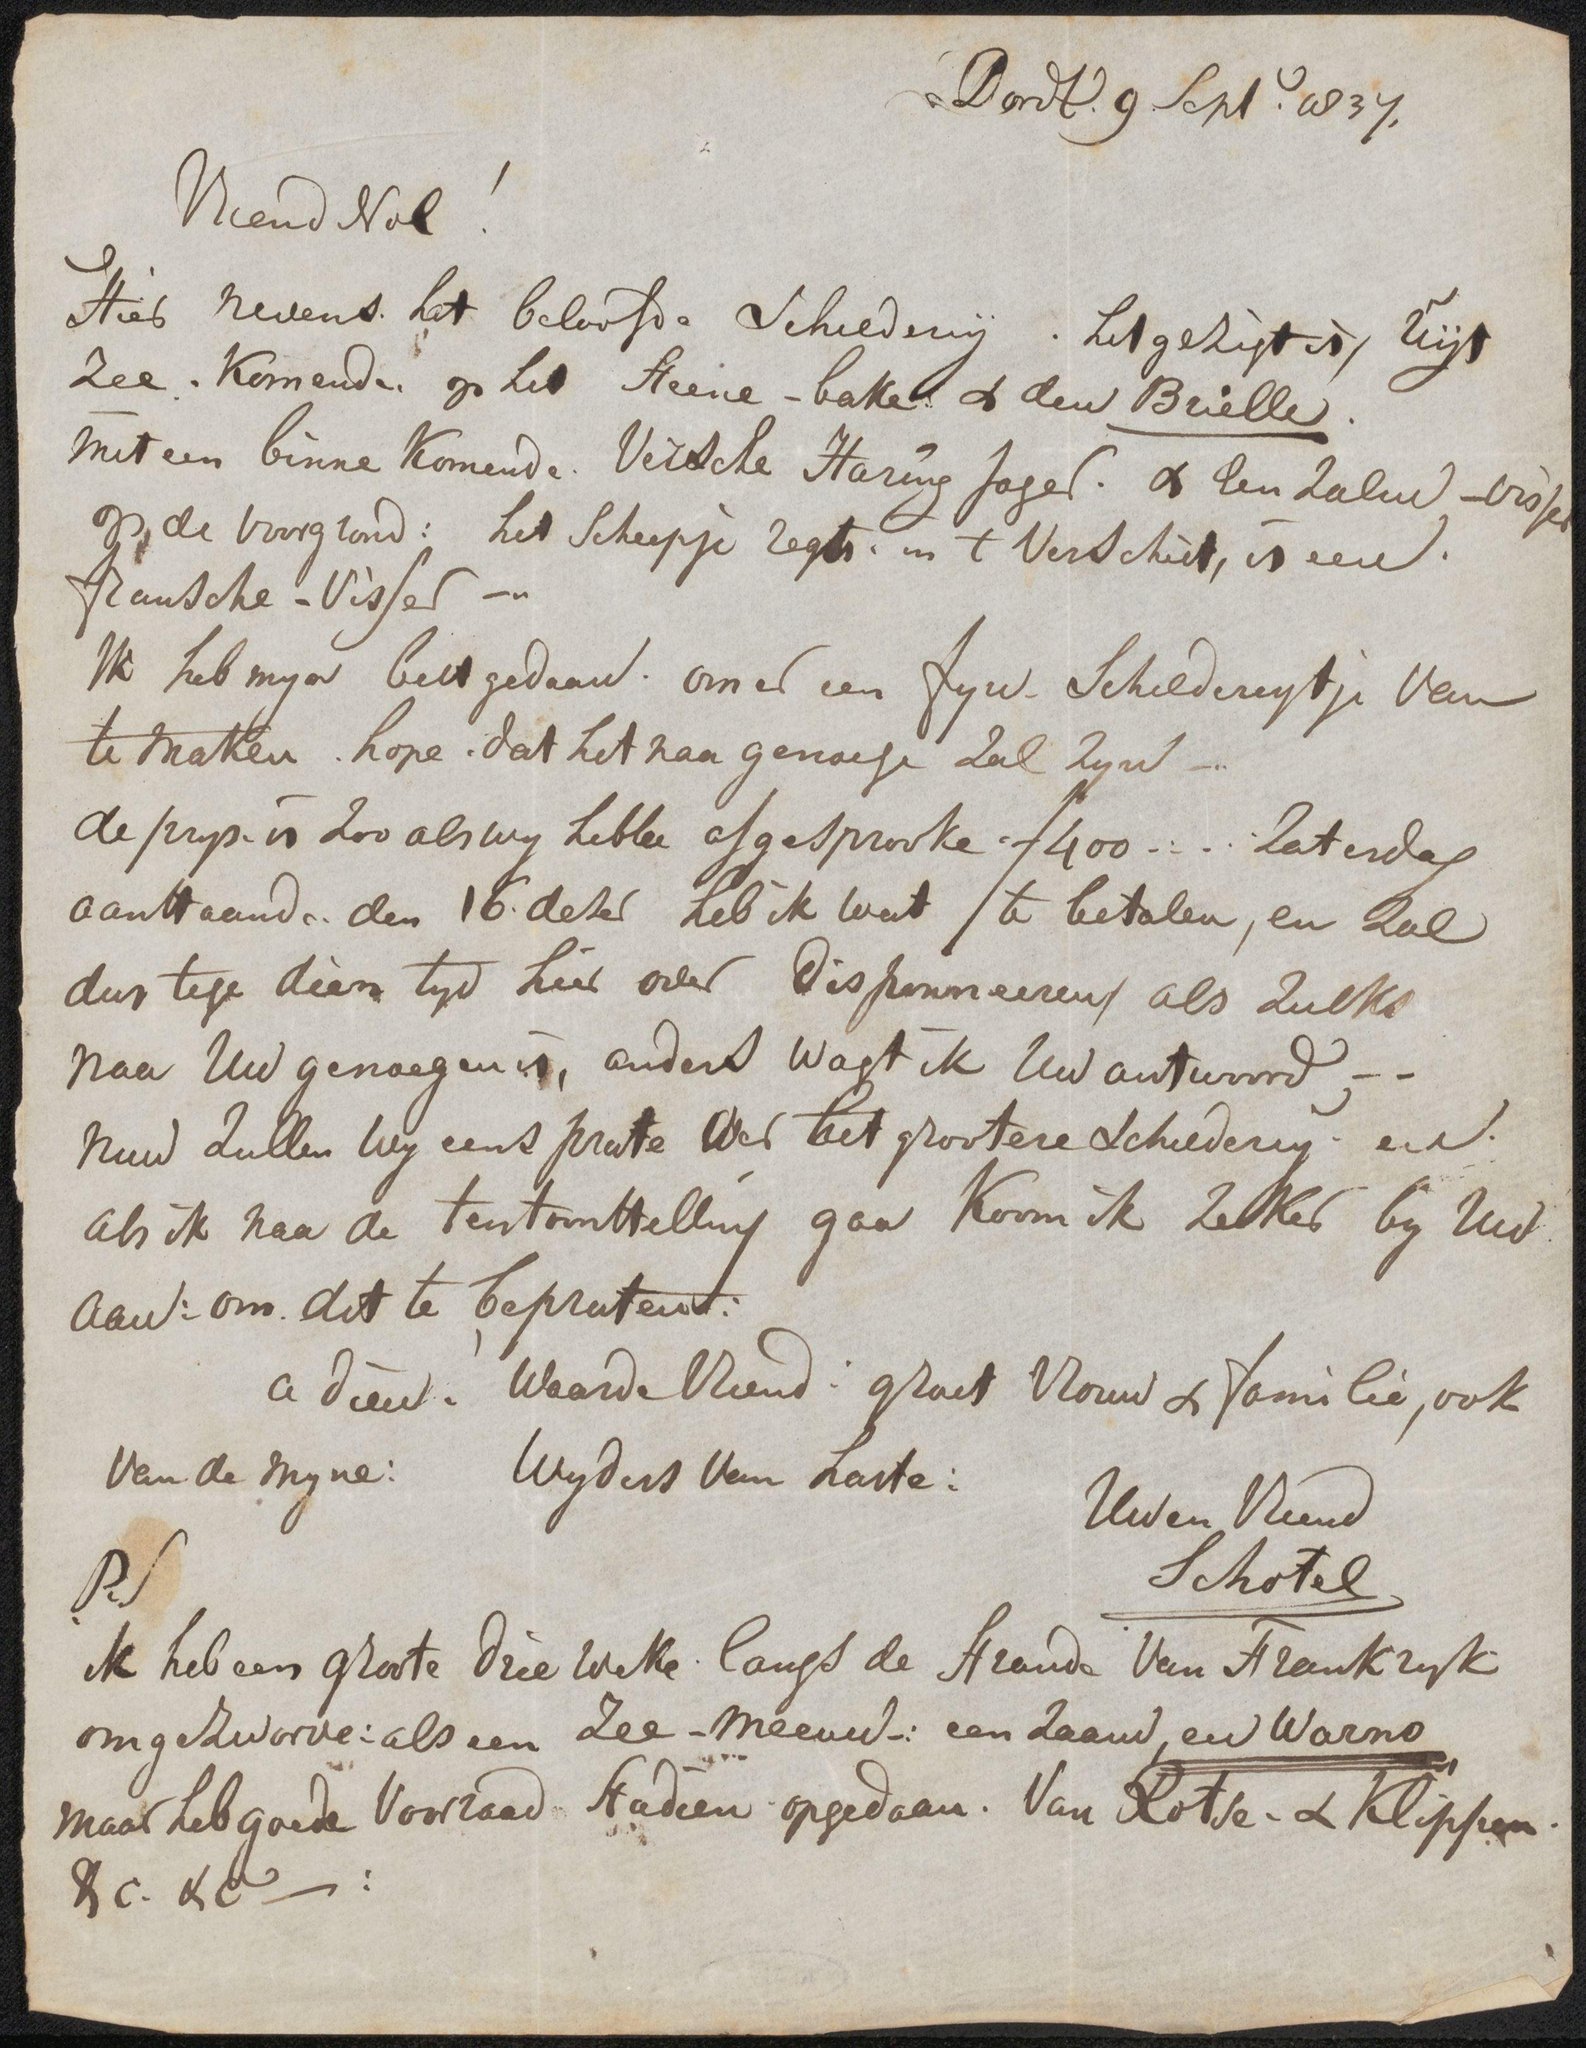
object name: letter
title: Brief aan Arnoldus Lamme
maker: johannes christiaan schotel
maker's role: draughtsman, painter, print maker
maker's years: 1787-1838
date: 1837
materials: ink, paper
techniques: pen, writing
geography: dordrecht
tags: rotterdam, arnoldus lamme, art trade, art shop, painting (including book-illumination, miniature-painting), france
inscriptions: collector's mark: Lugt 2228